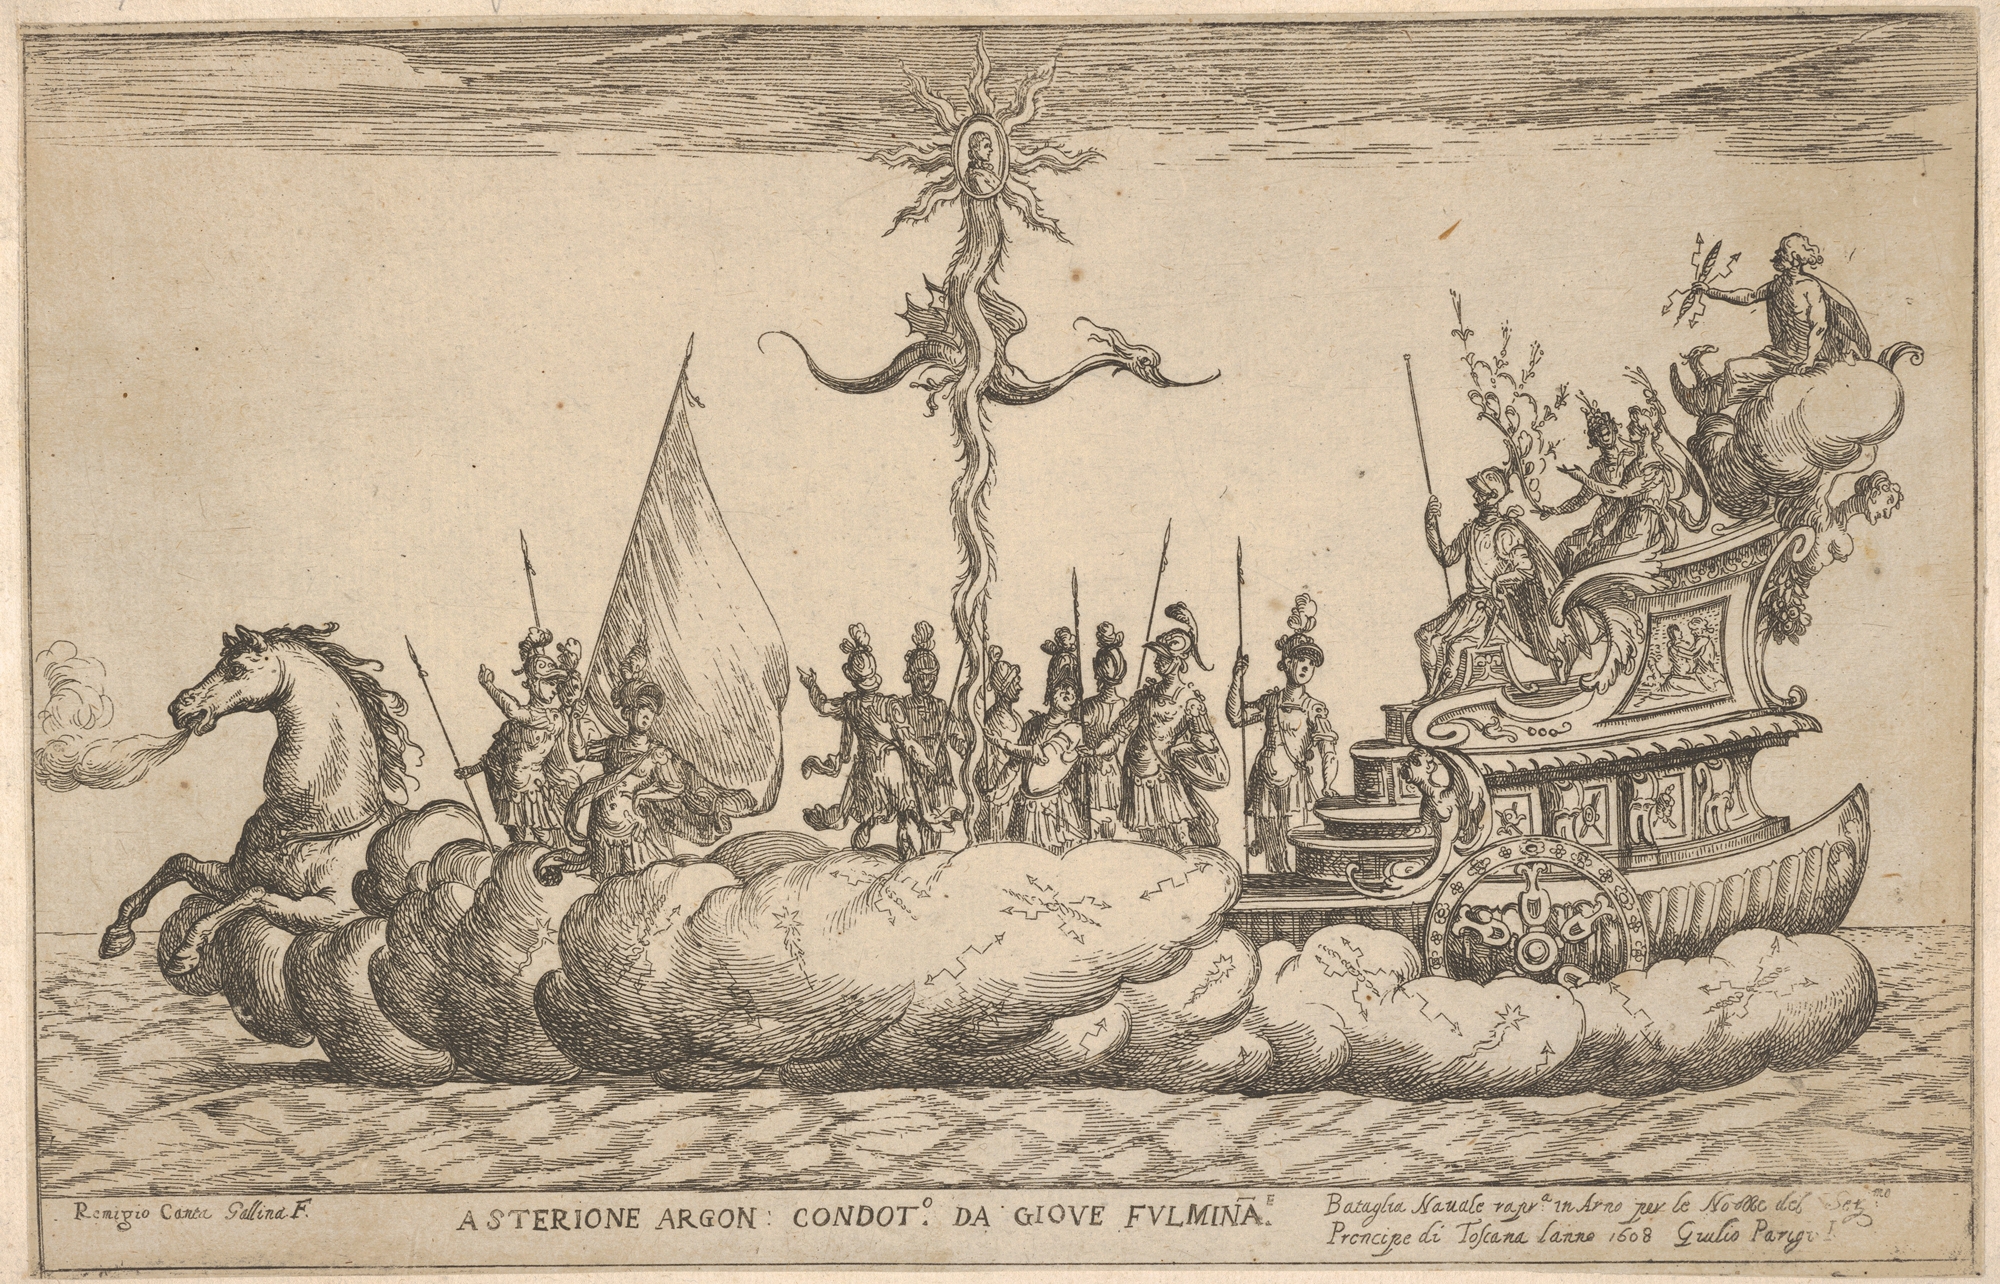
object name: print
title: Asterion, from "Vessels of the Argonauts"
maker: remigio cantagallina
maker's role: artist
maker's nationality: italian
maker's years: 1582-1656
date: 1608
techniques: etching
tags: soldiers,horses,flags,ships